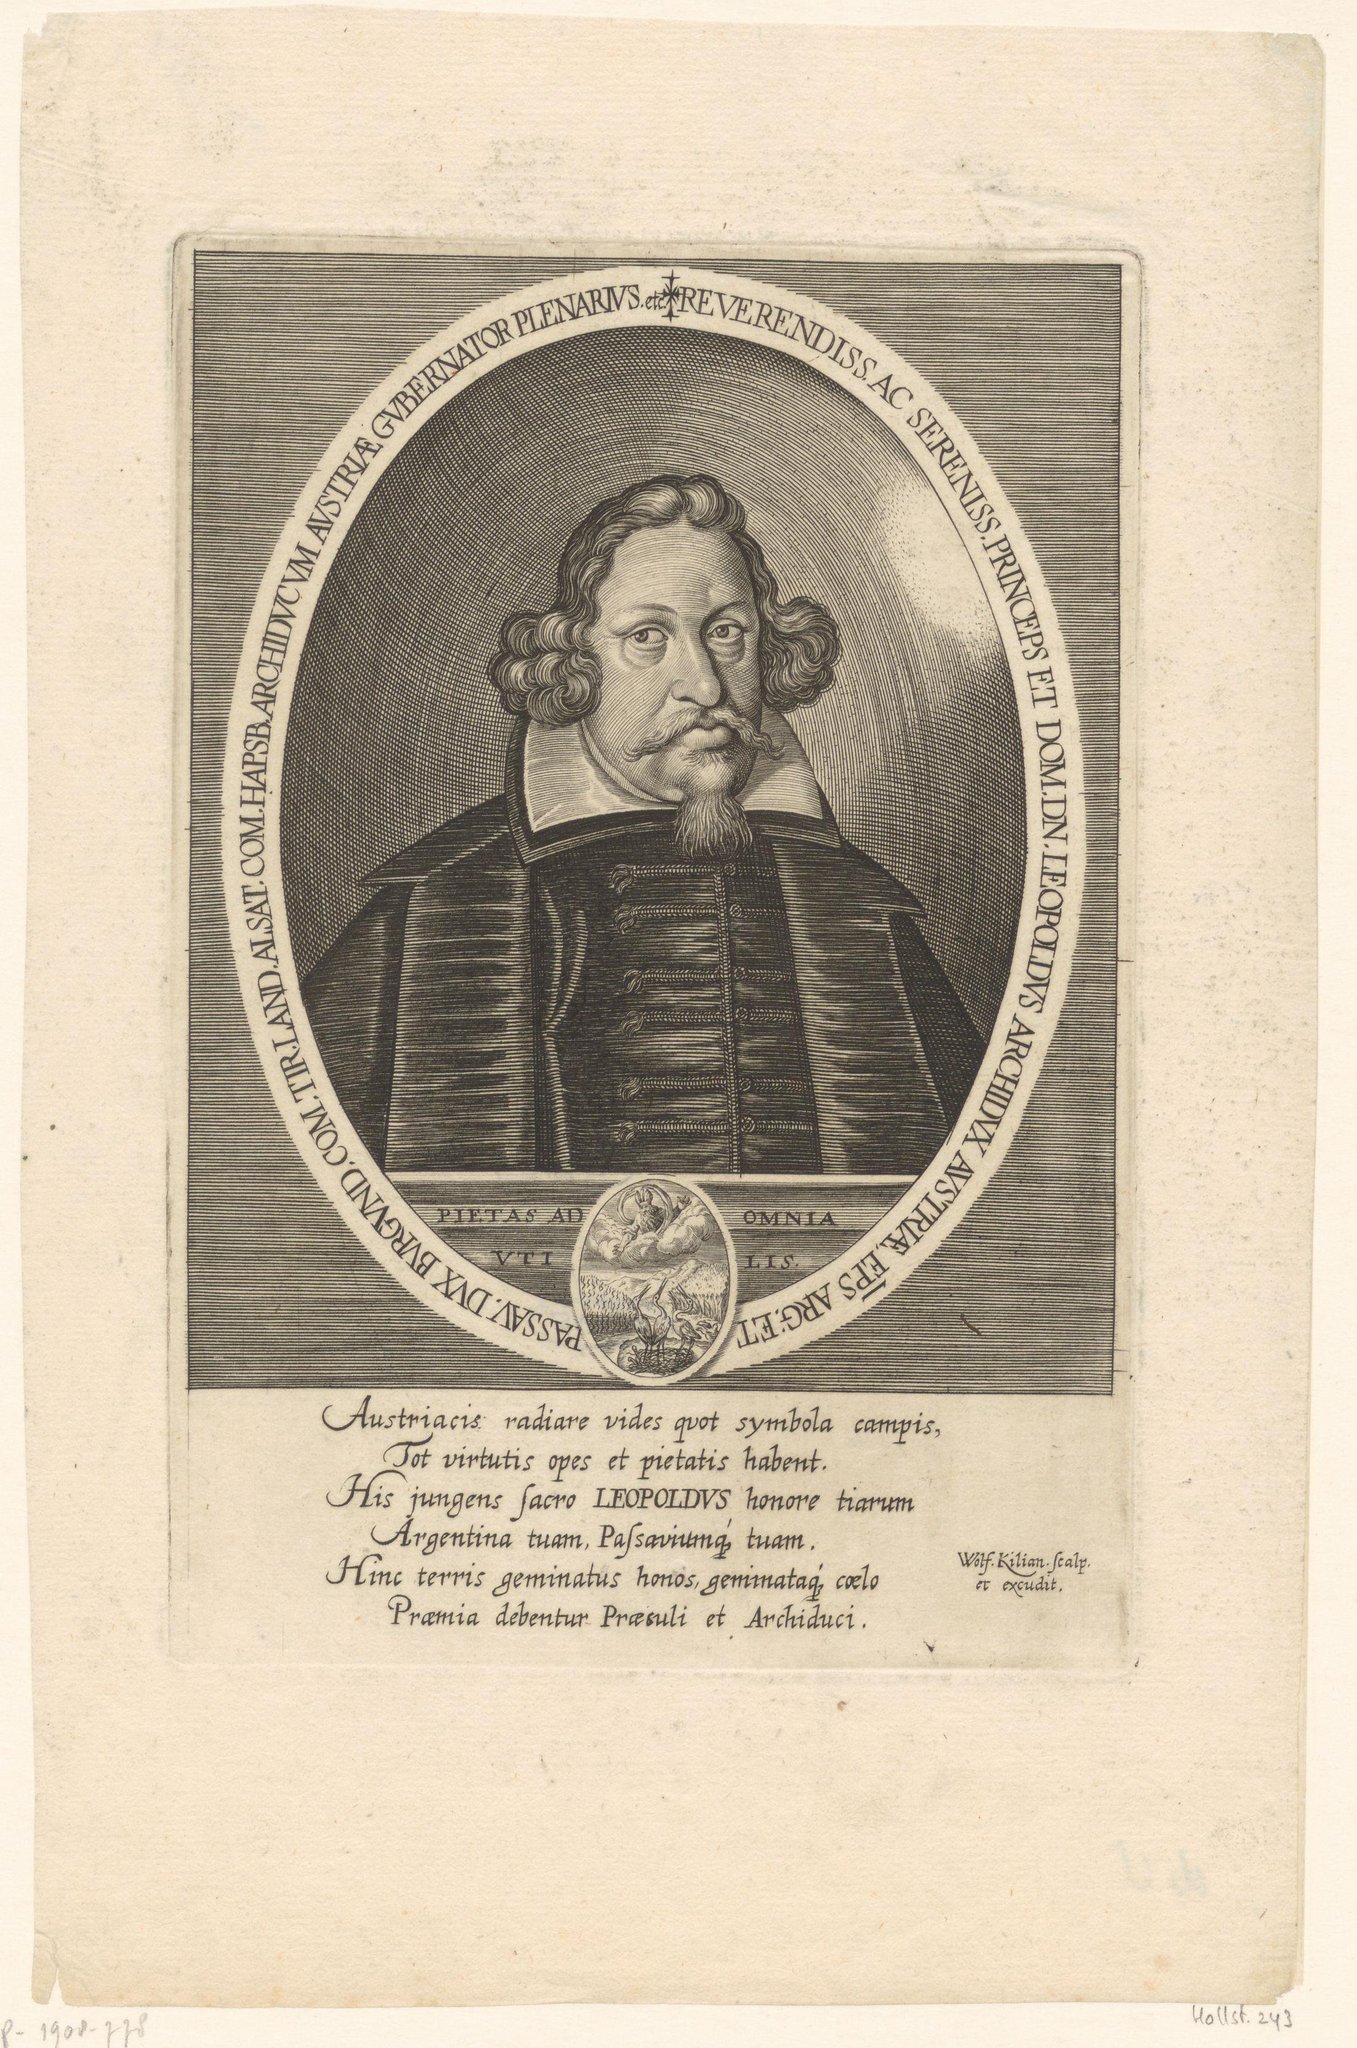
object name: print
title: Portret van Leopold V van Oostenrijk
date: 1596-1662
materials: paper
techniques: engraving, etching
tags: leopold v (aartshertog van oostenrijk), historical persons, regent, substitute ruler; viceroy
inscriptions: collector's mark: Lugt 2228, collector's mark: Lugt 2228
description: Tekst in het Latijn in de omlijsting en in de ondermarge.